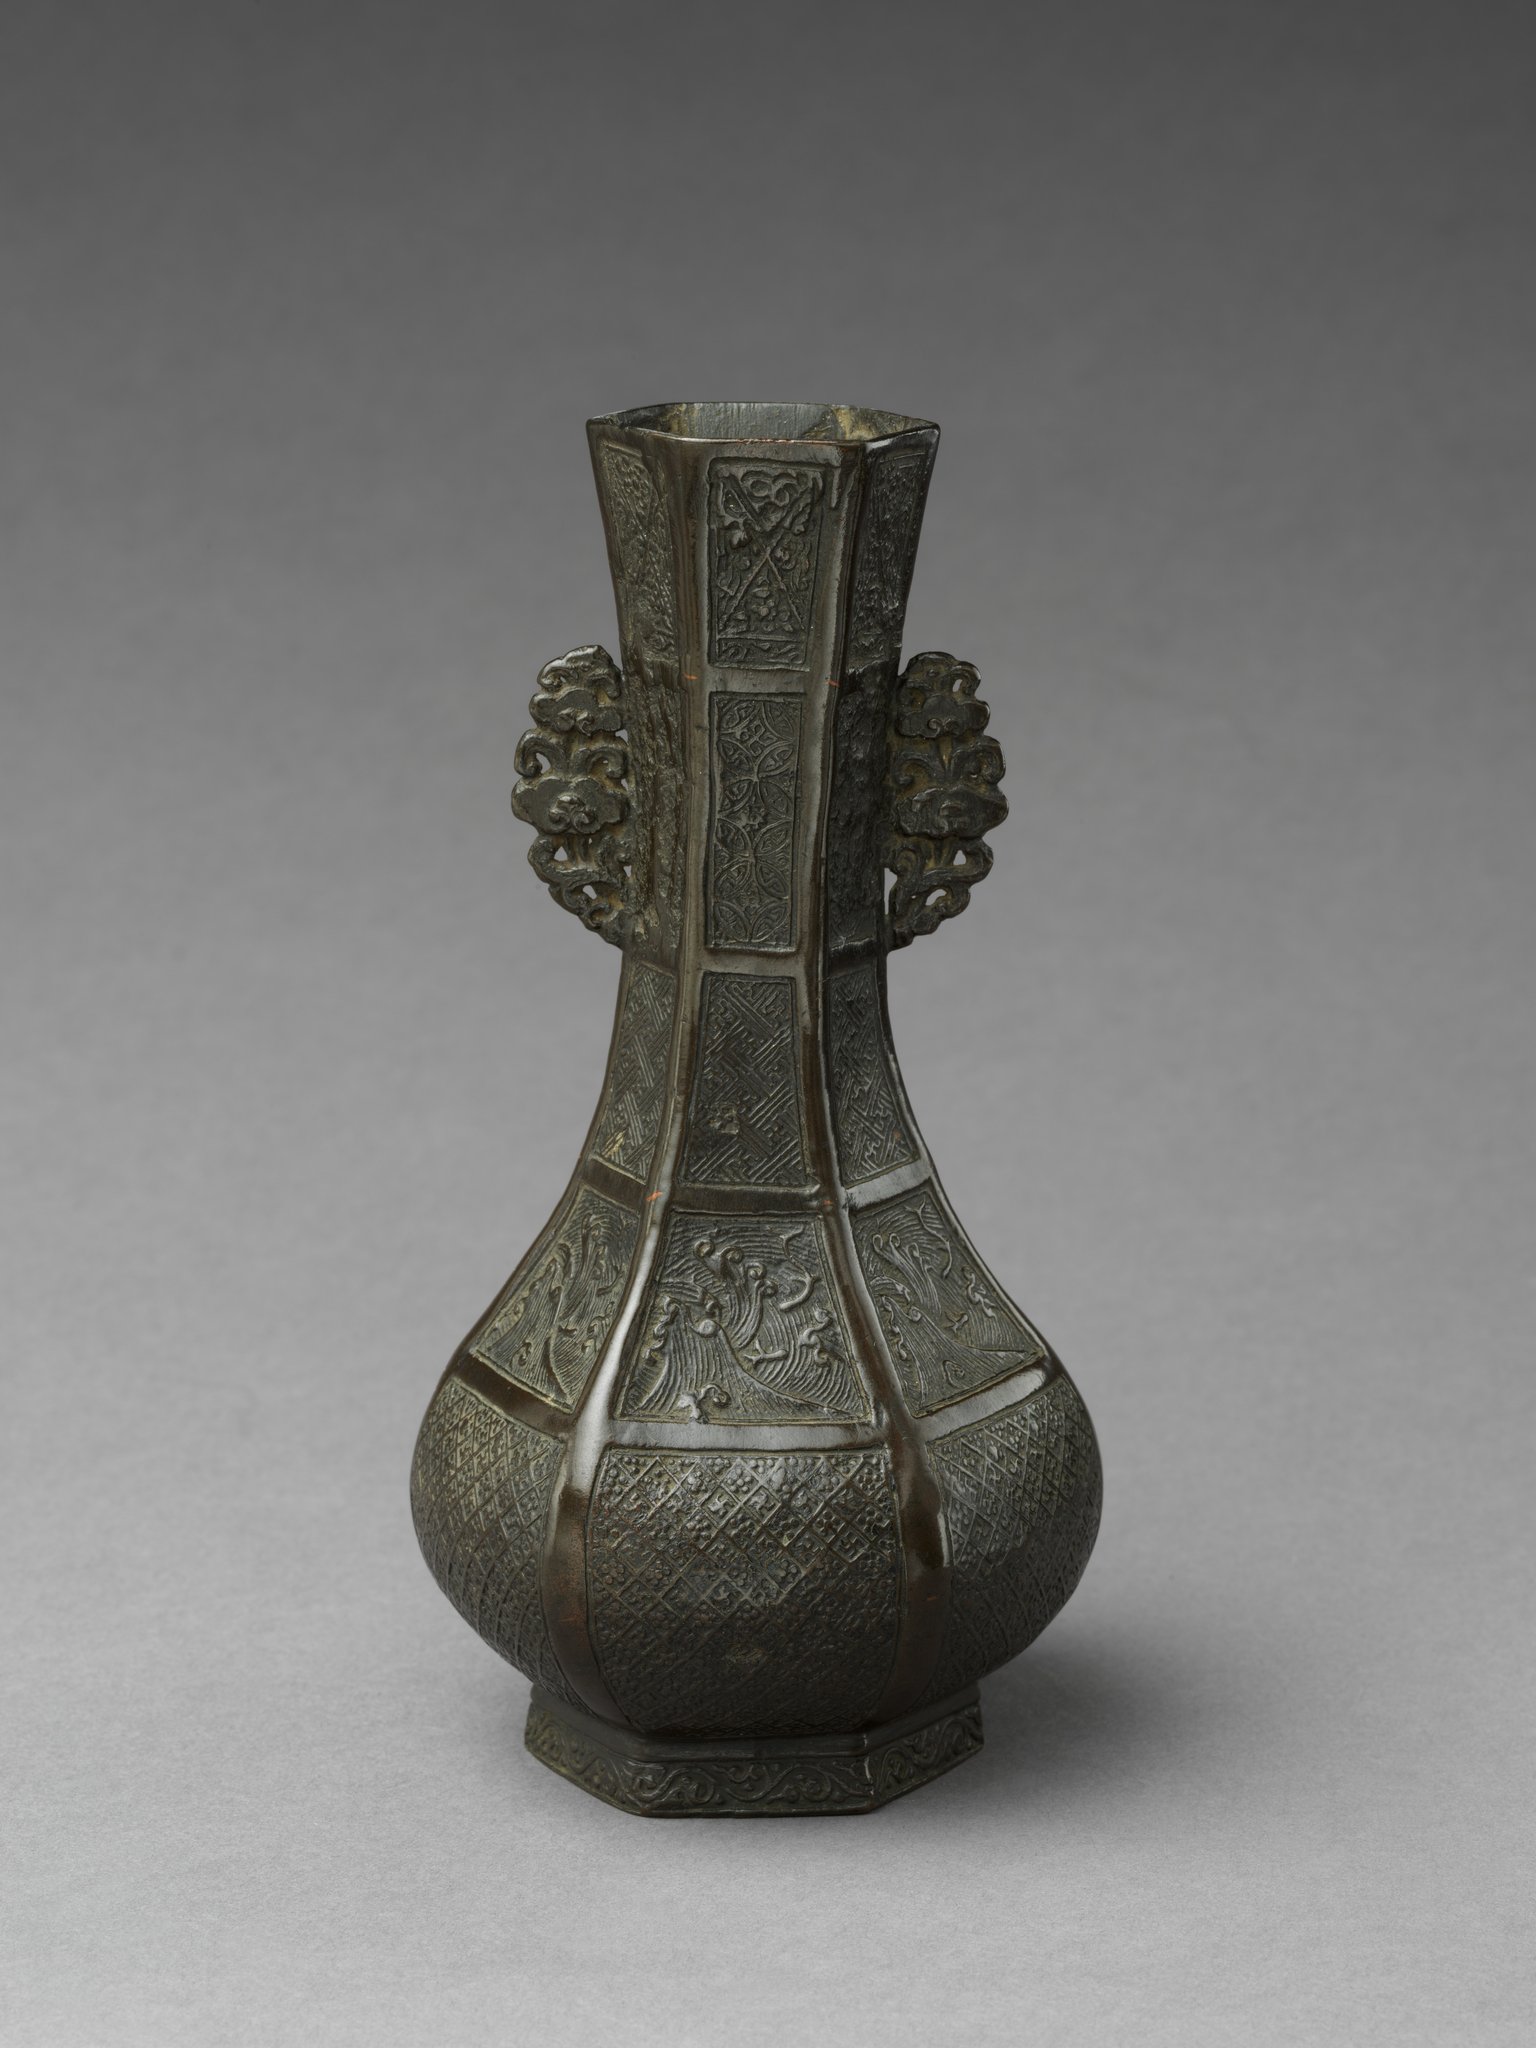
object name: vase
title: Hexagonal flower vase with magic fungus handles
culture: chinese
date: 1301-1400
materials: copper alloy